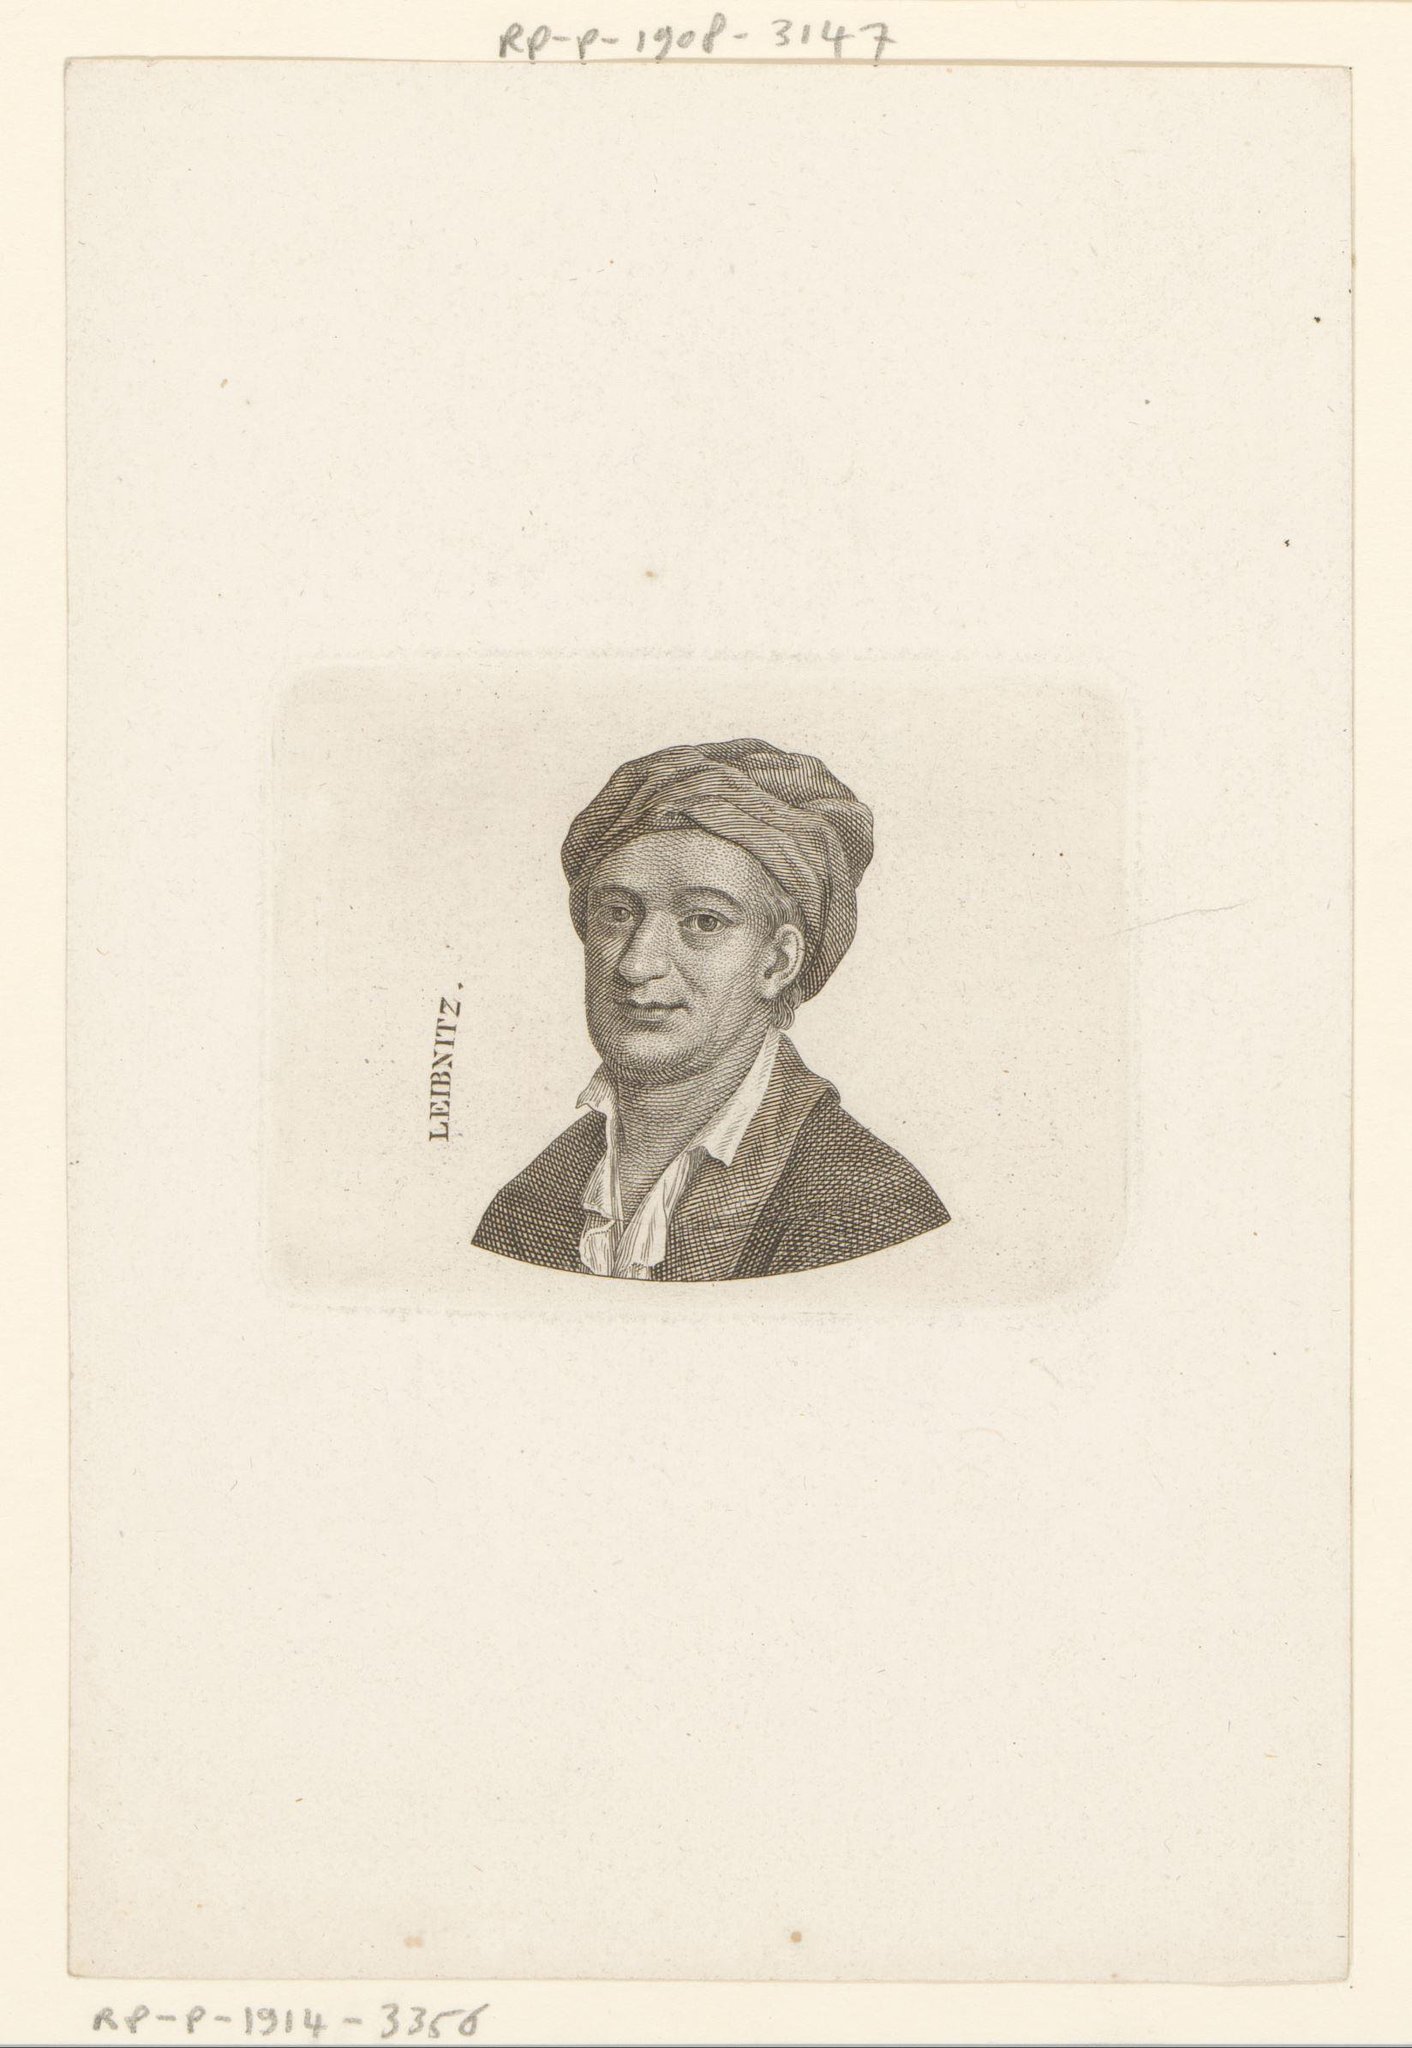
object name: print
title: Portret van Gottfried Wilhelm Leibniz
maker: ernst ludwig riepenhausen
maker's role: print maker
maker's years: 1765-1840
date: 1775-1840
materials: paper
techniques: engraving, intaglio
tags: historical persons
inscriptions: collector's mark: Lugt 2228